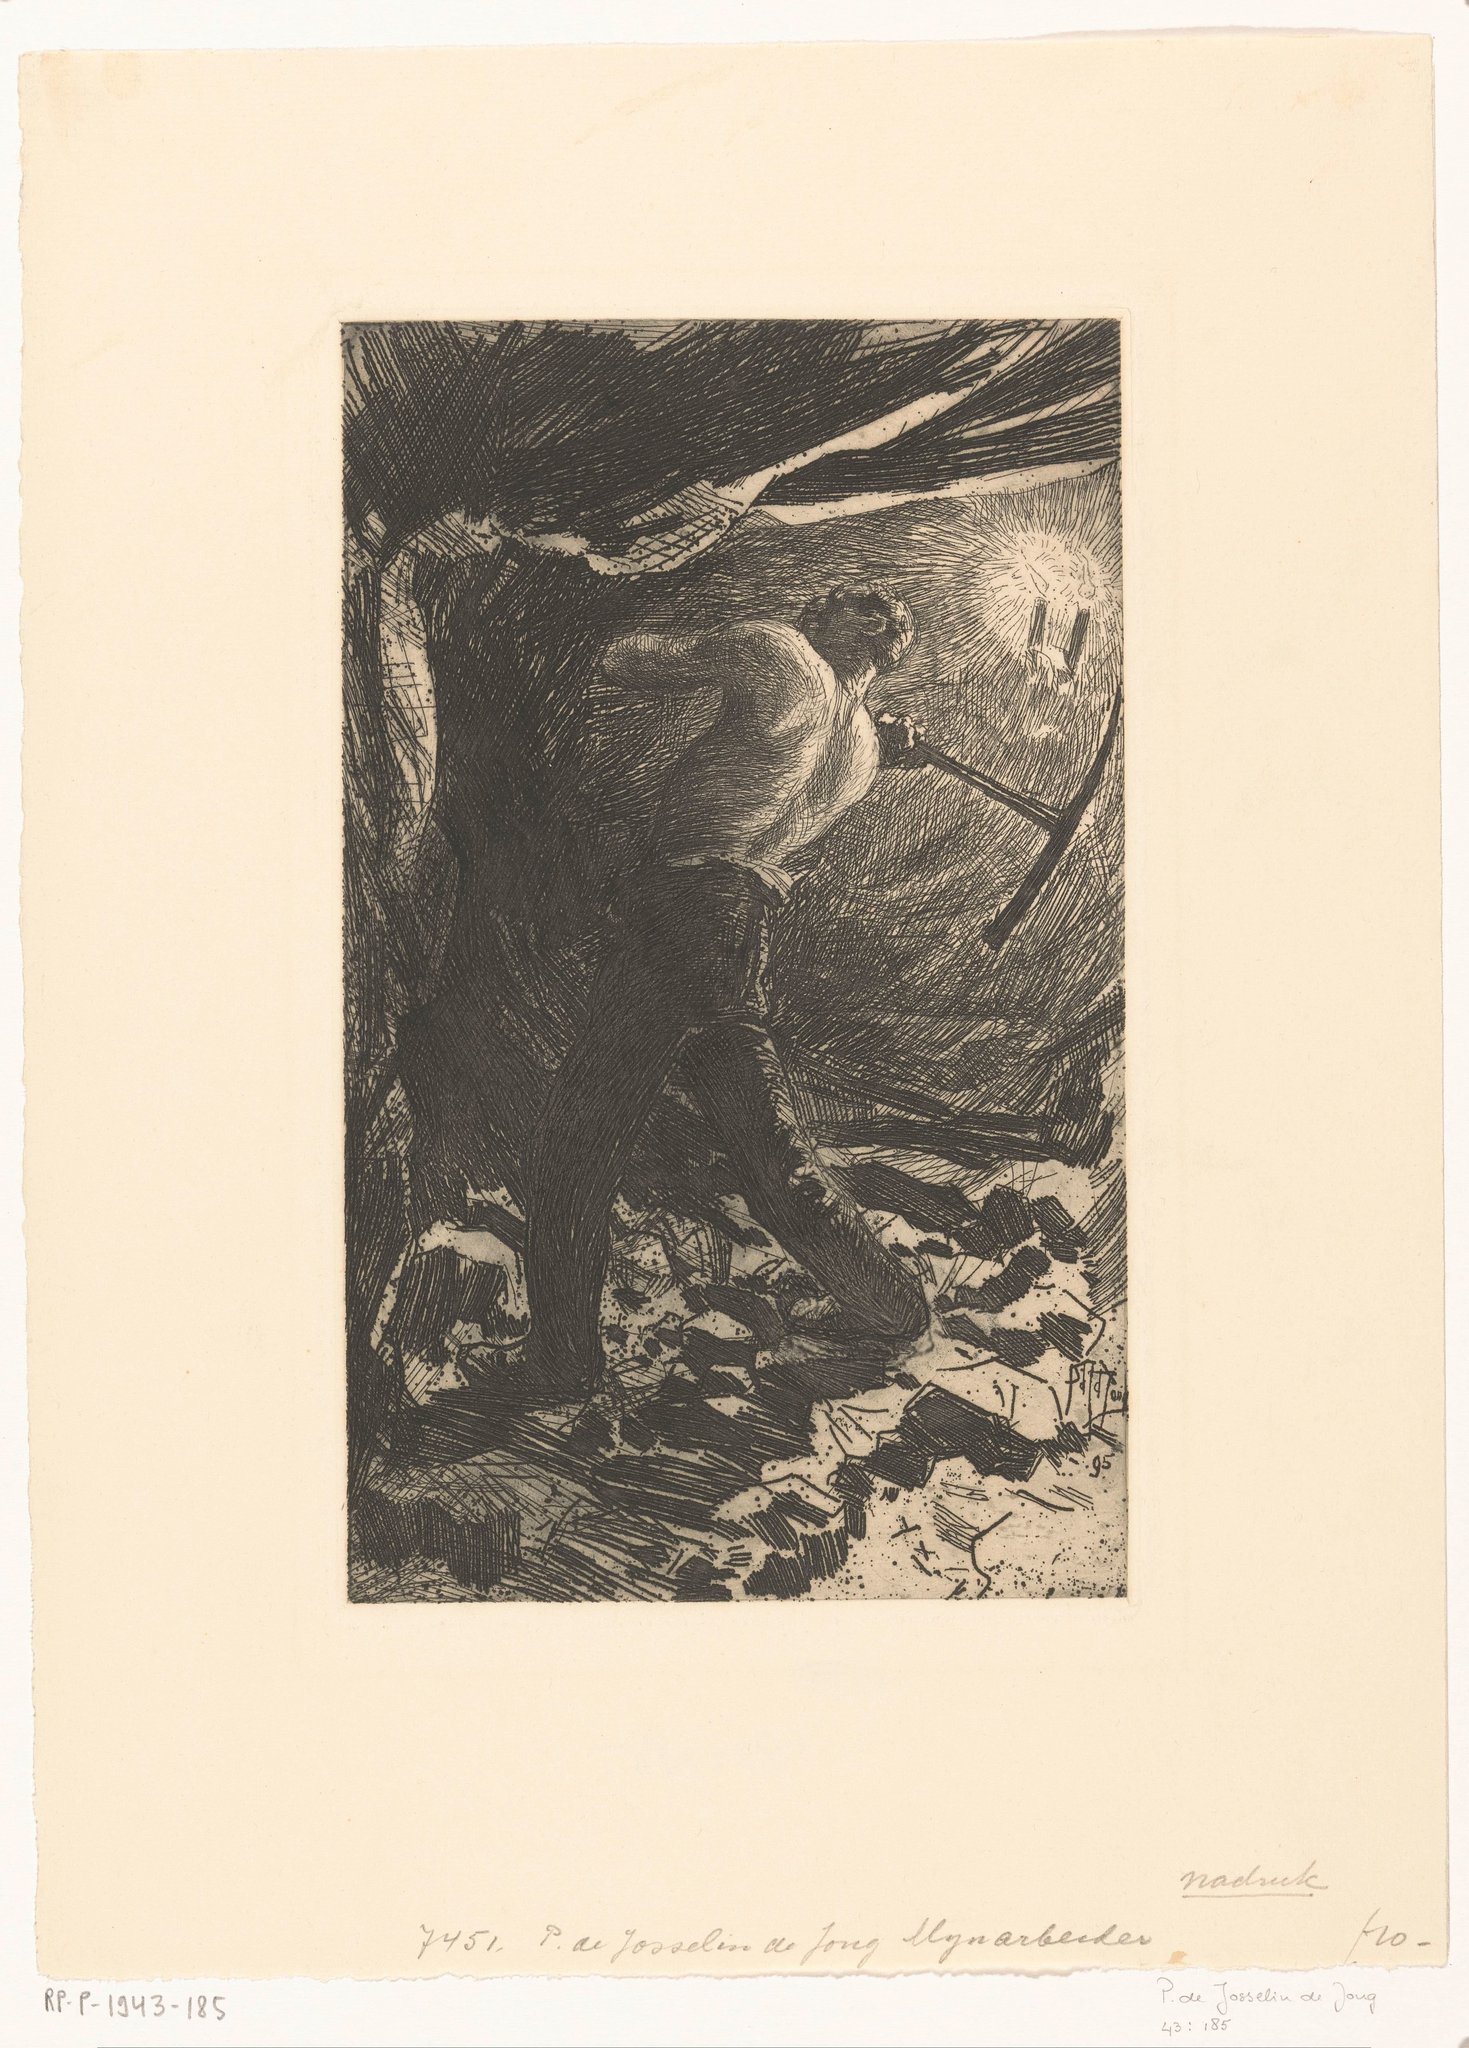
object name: print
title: Mijnarbeider met bloot bovenlijf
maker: pieter de josselin de jong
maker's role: draughtsman, painter, print maker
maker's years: 1861-1906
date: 1895-1943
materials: paper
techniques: etching, intaglio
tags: miner, partially clothed, candle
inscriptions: collector's mark: Lugt 2760, collector's mark: Lugt 2228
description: De man heeft een pikhouweel in zijn handen. Rechts op de achtergrond twee kaarsen die de mijnschacht verlichten.